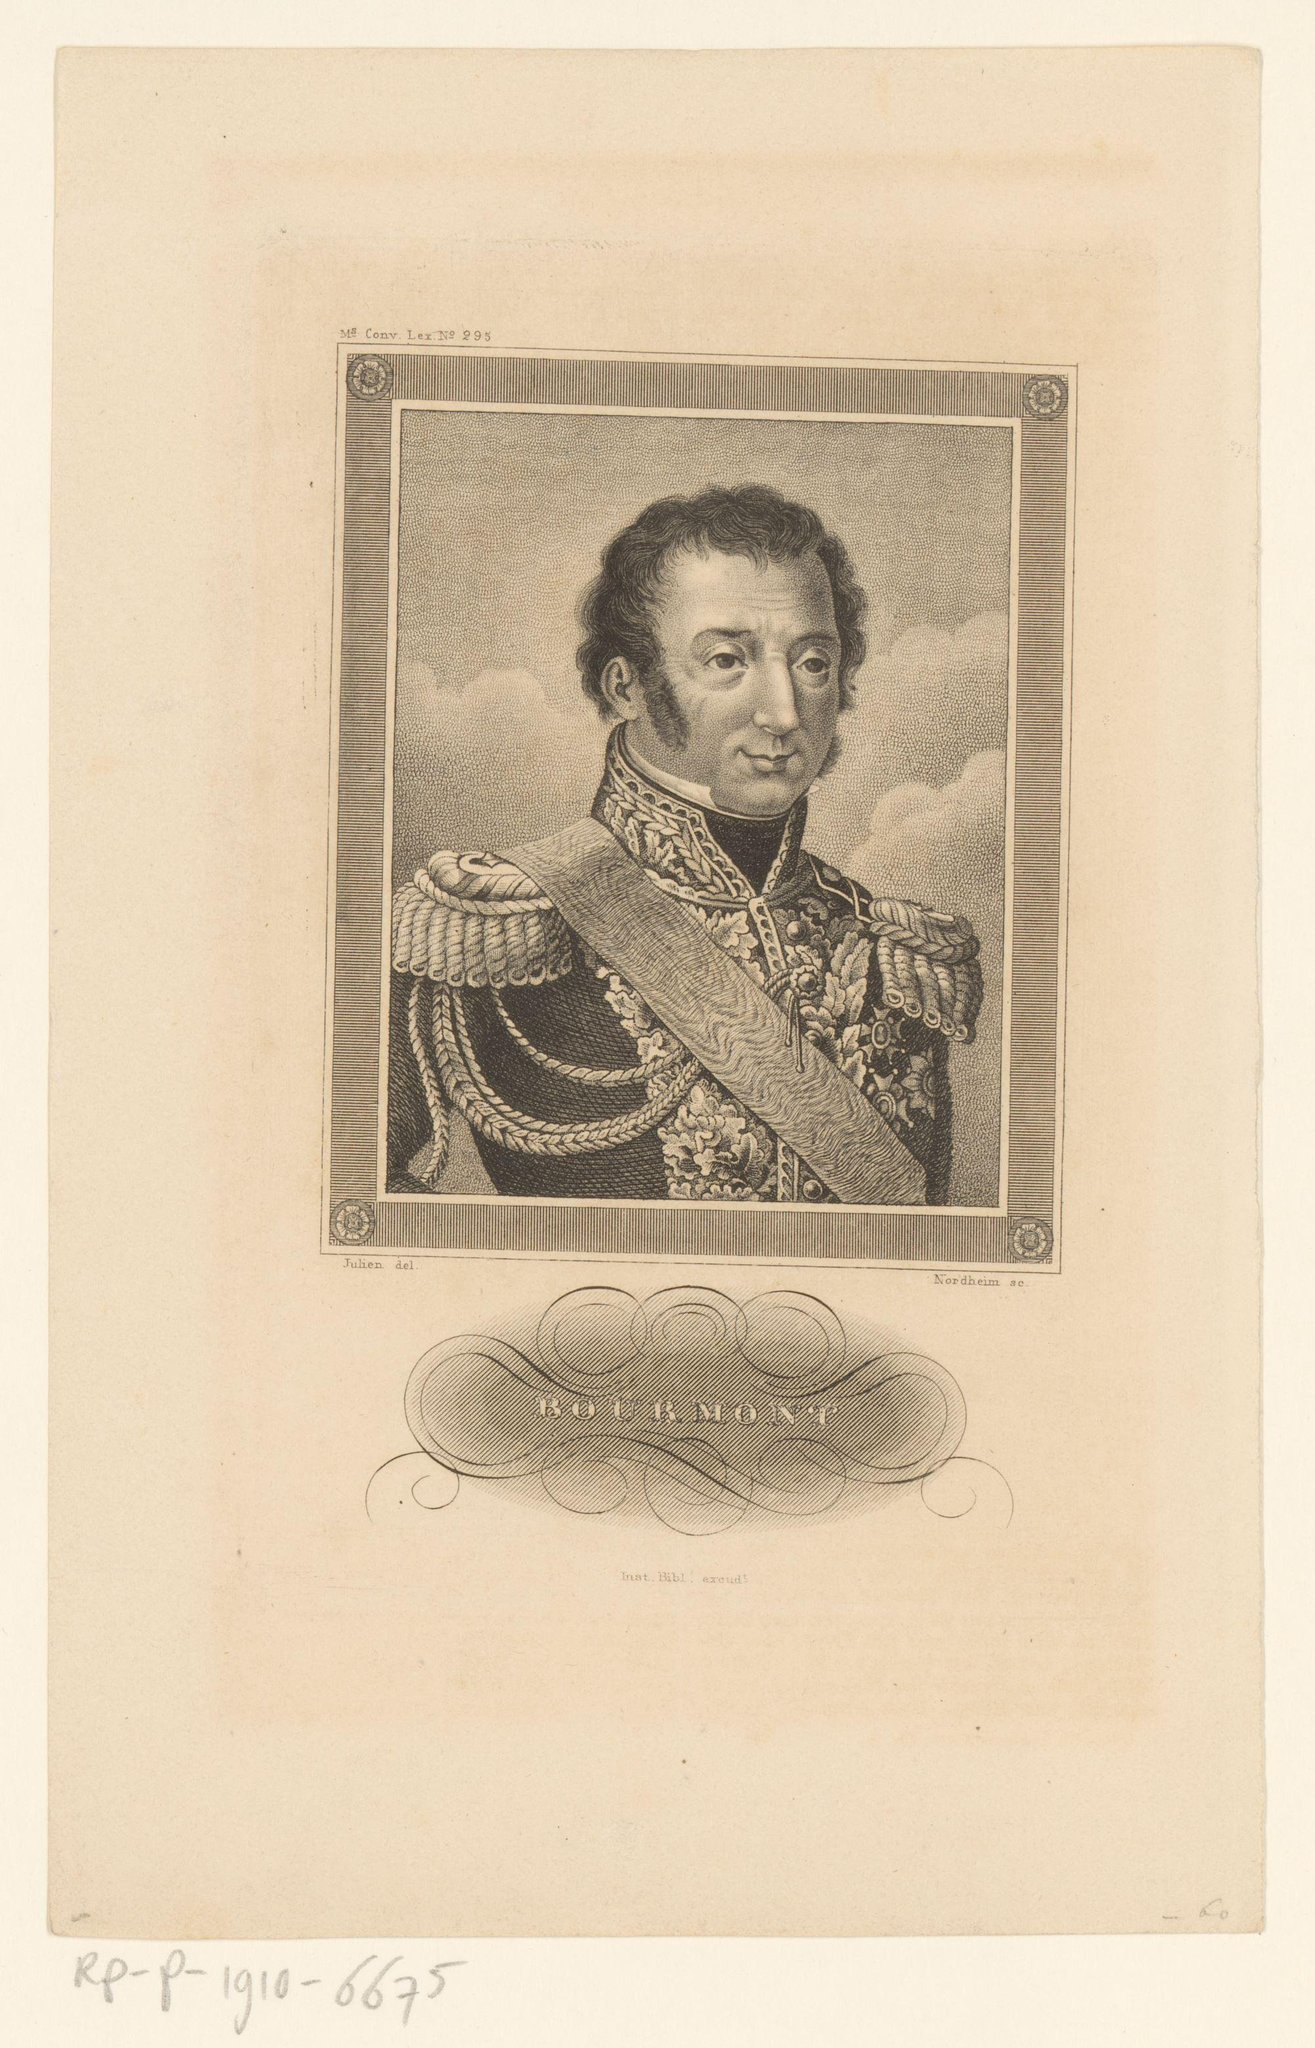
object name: book illustration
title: Portret van Louis Auguste Victor de Ghaises de Bourmont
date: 1840-1855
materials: paper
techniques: etching, engraving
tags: historical persons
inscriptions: collector's mark: Lugt 2228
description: Prent afkomstig uit: Conversations-Lexikon für die gebildeten Stände, voor het eerst uitgegeven tussen 1840-1855.